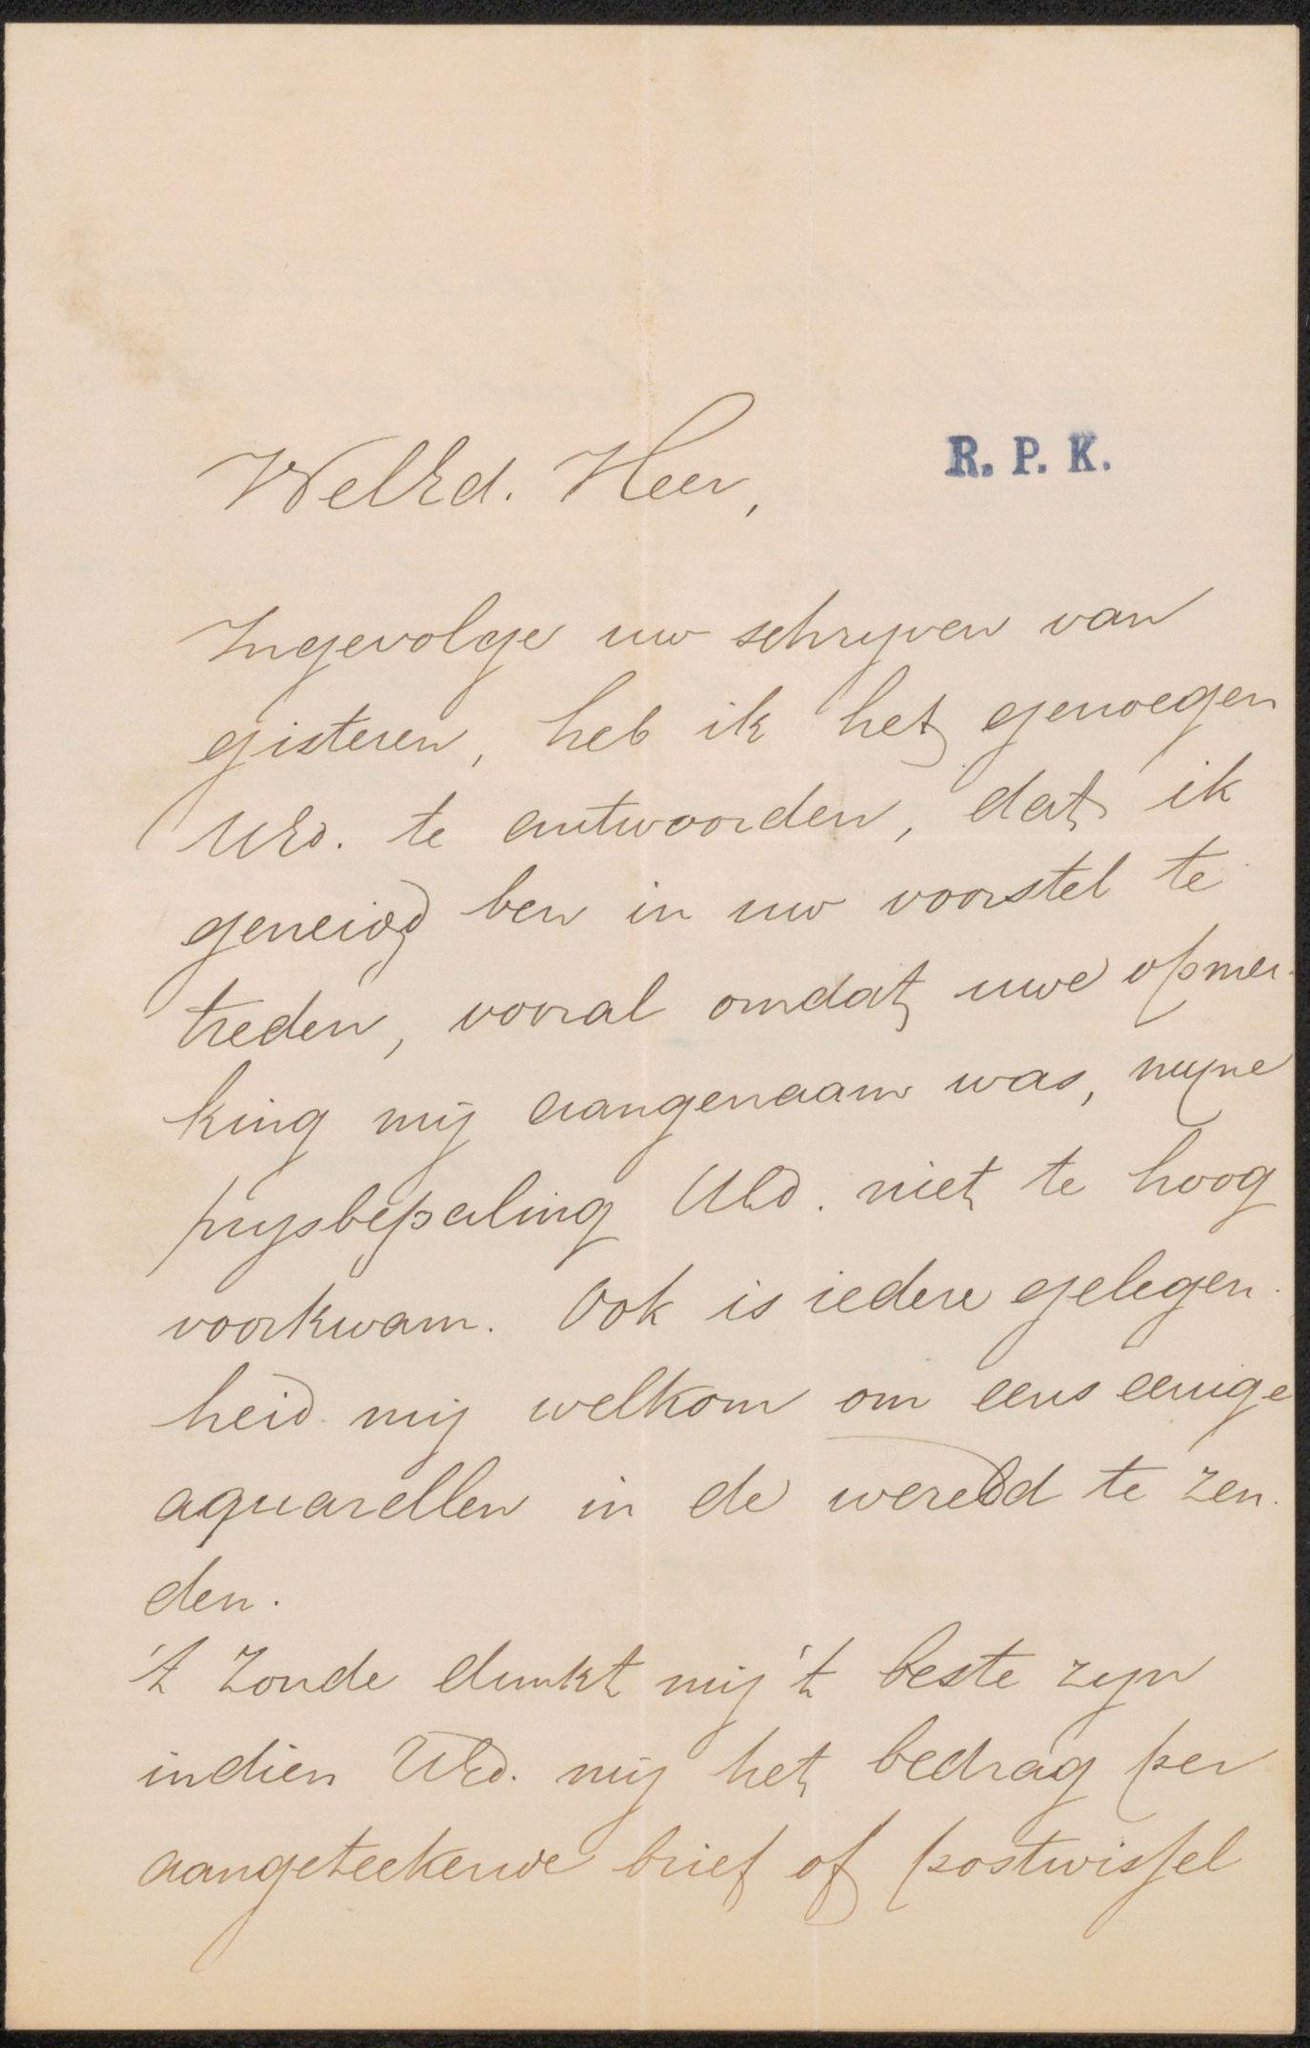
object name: letter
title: Brief aan Frans Buffa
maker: sebastiaan m.s. de ranitz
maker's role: draughtsman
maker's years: 1846-1916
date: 1872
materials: ink, paper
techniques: pen, writing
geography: the hague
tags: printer, frans buffa, drawing, money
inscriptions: collector's mark: Lugt 2233